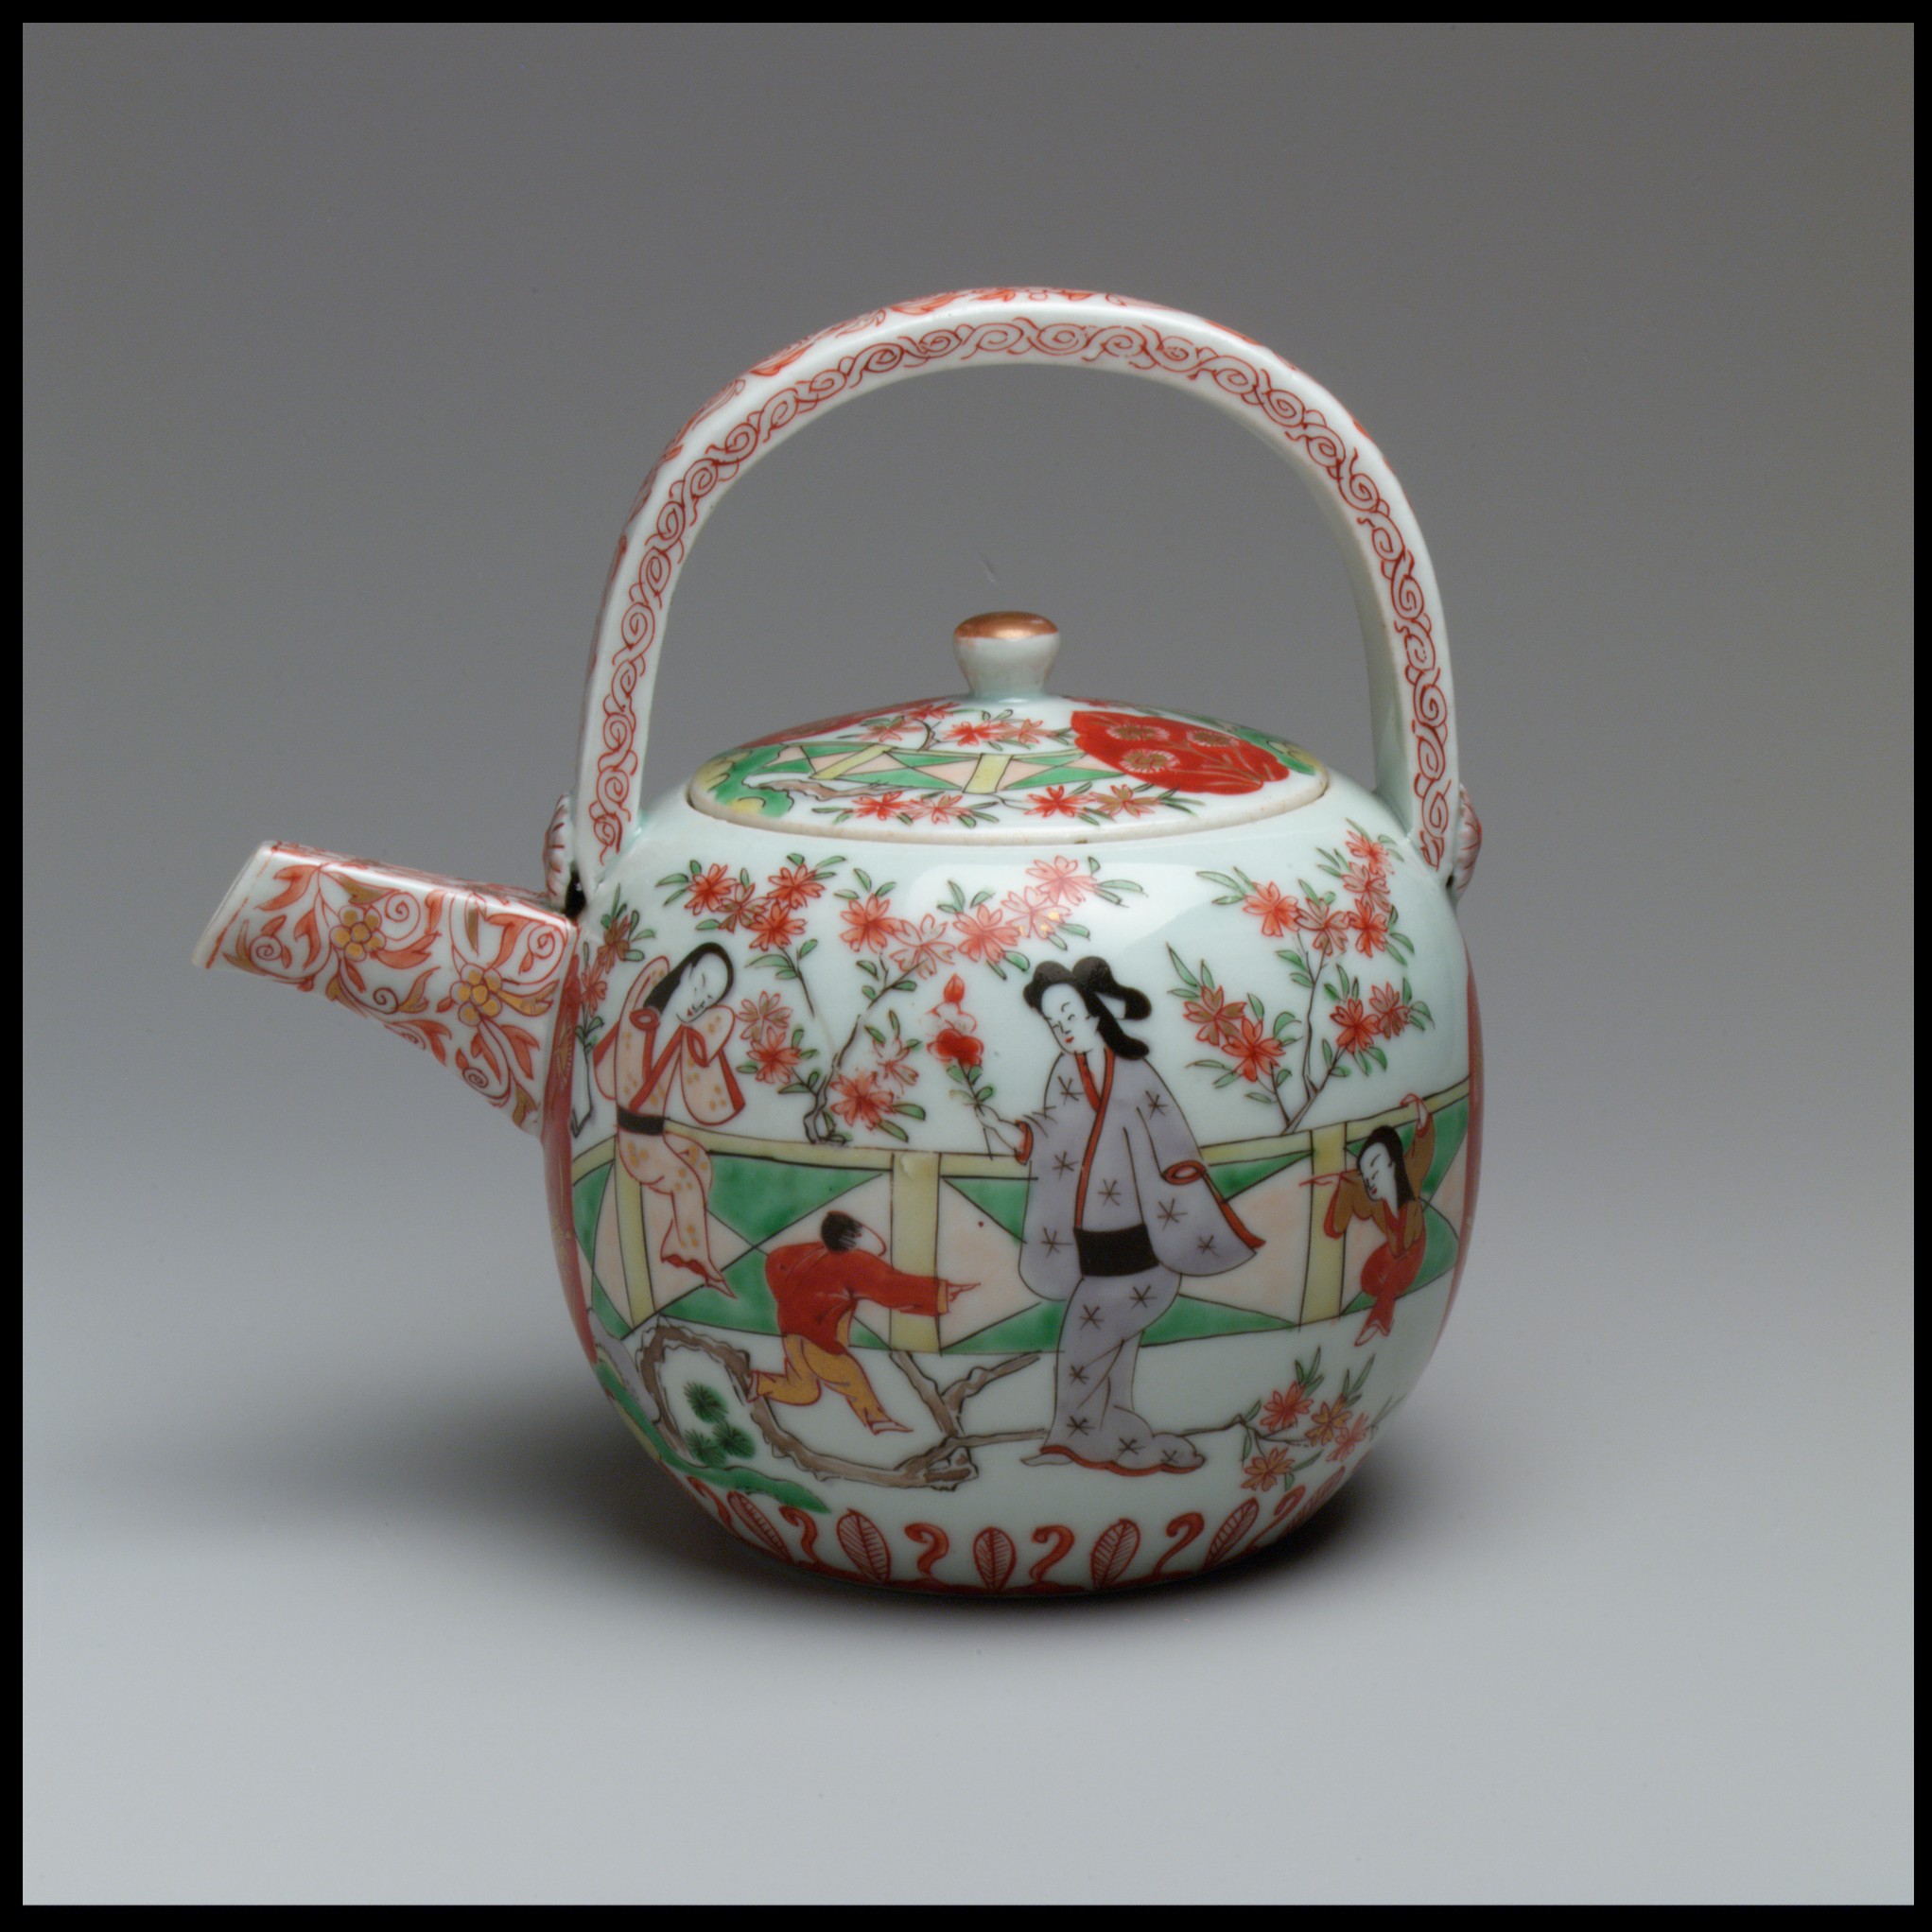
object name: wine pot with cover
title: Wine pot and cover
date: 1801-1833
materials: hard paste porcelain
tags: children,women,playing,flowers